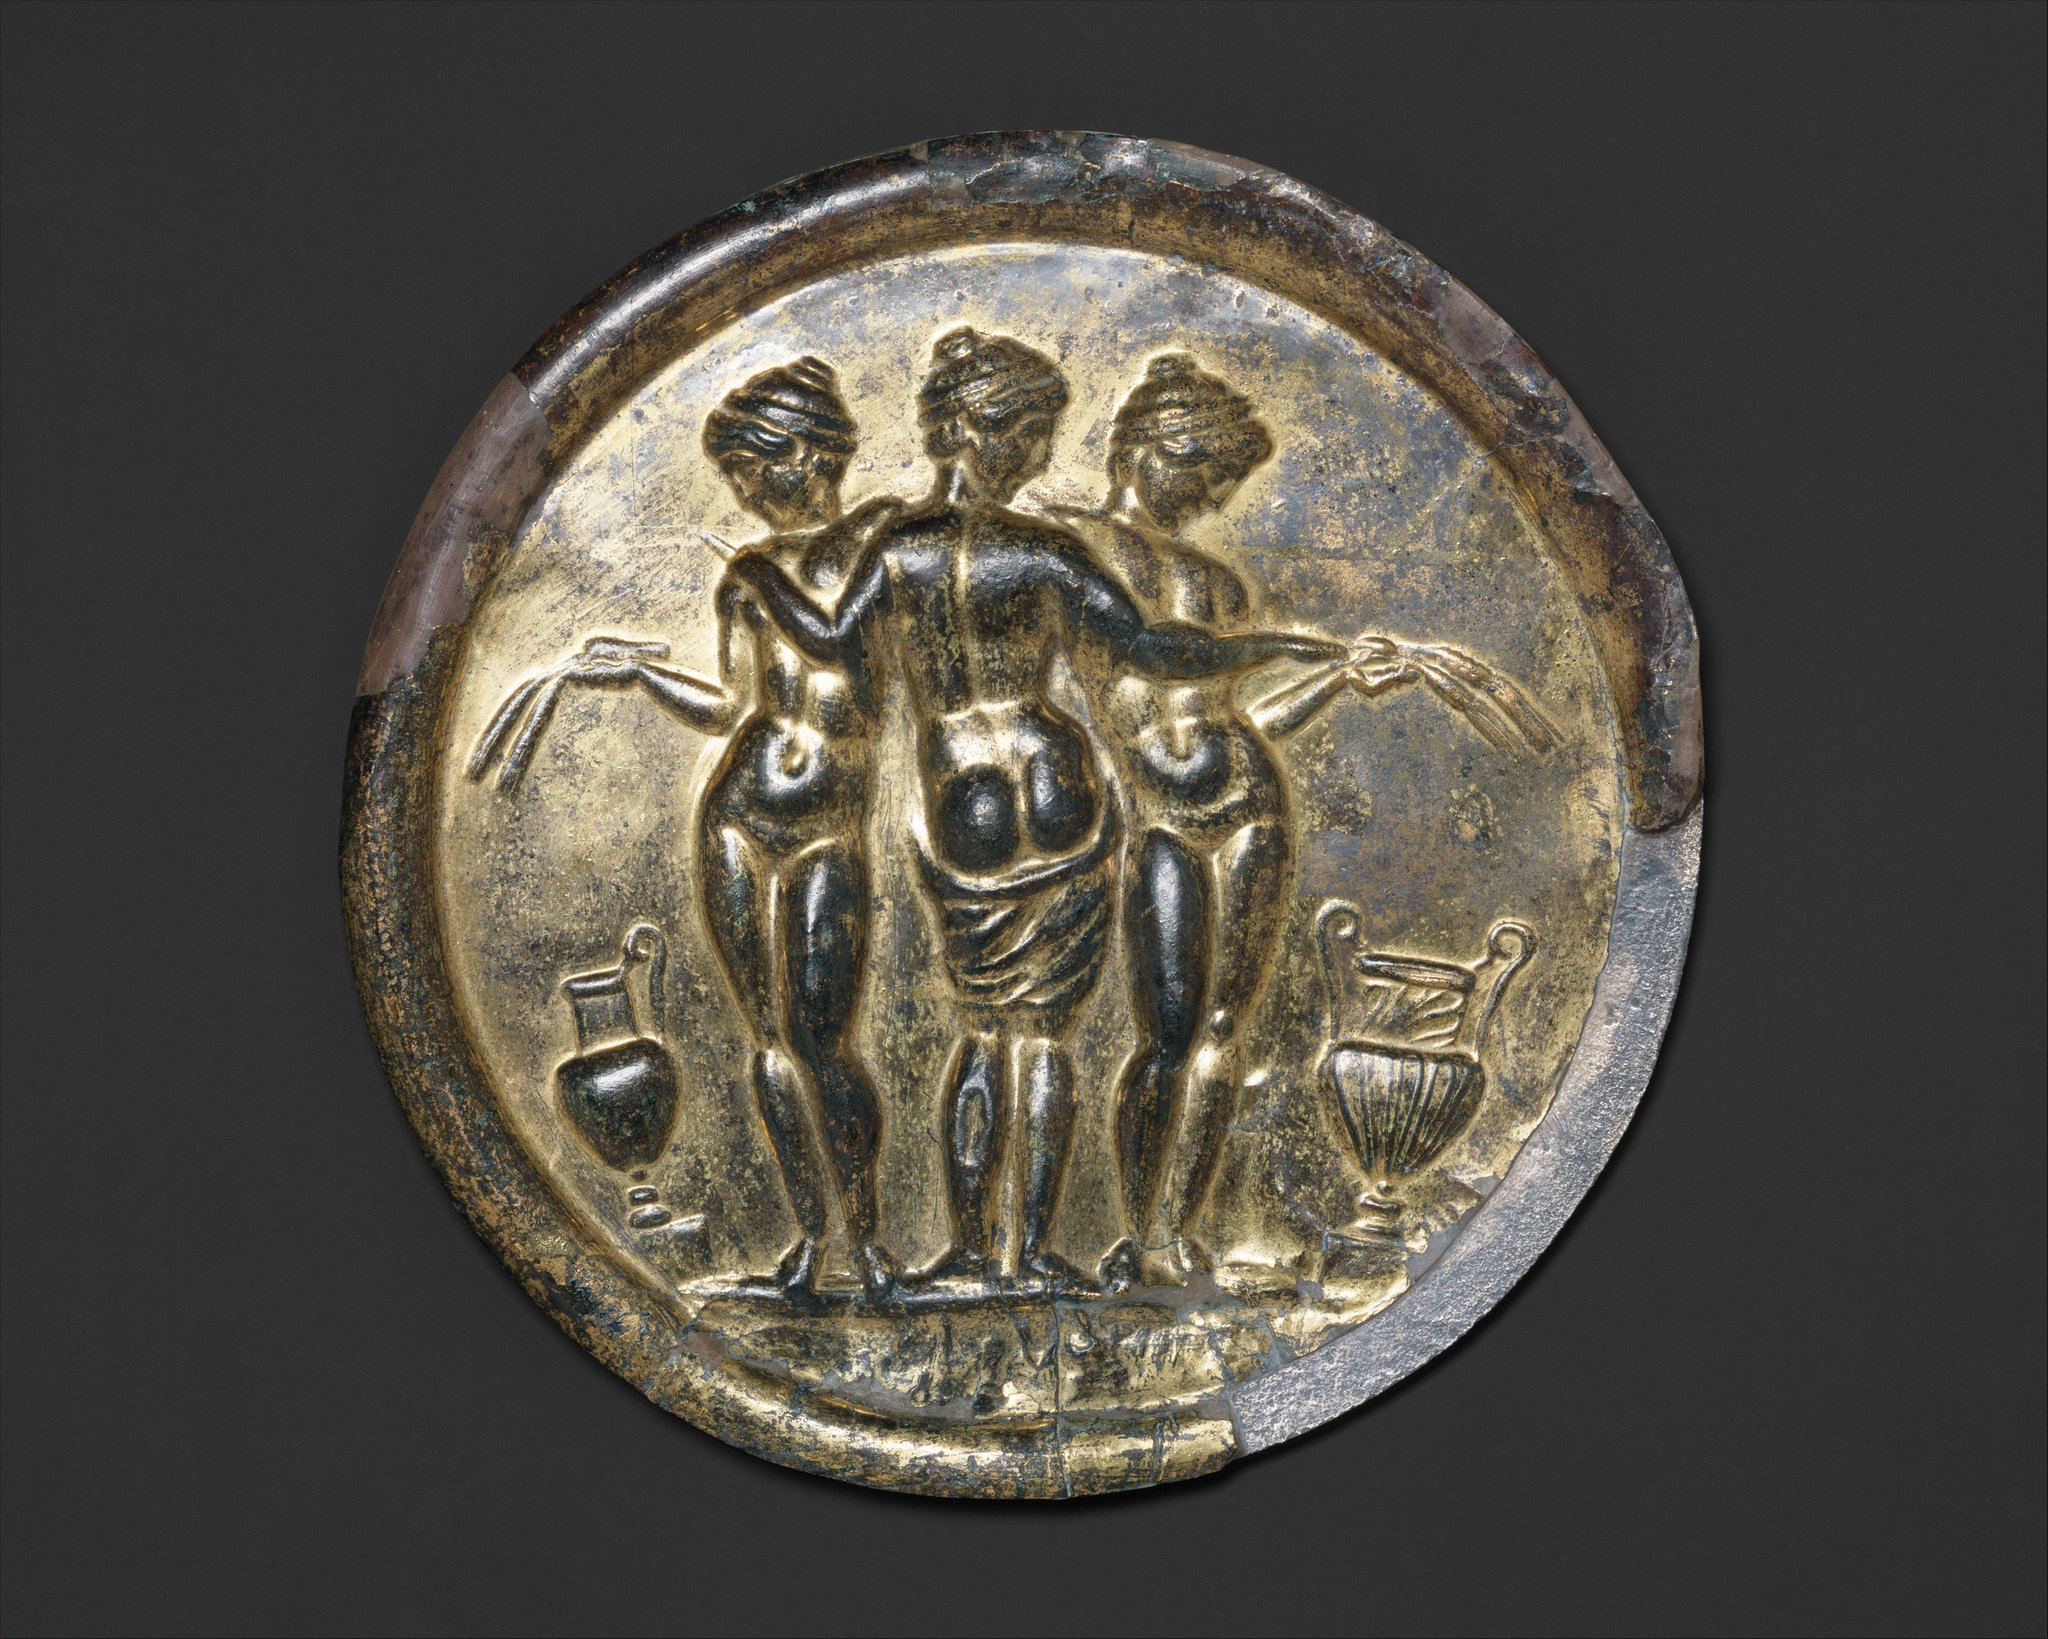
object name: mirror with three grace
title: Gilded bronze mirror with the Three Graces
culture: roman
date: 134-166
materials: bronze, gold, silver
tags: female nudes